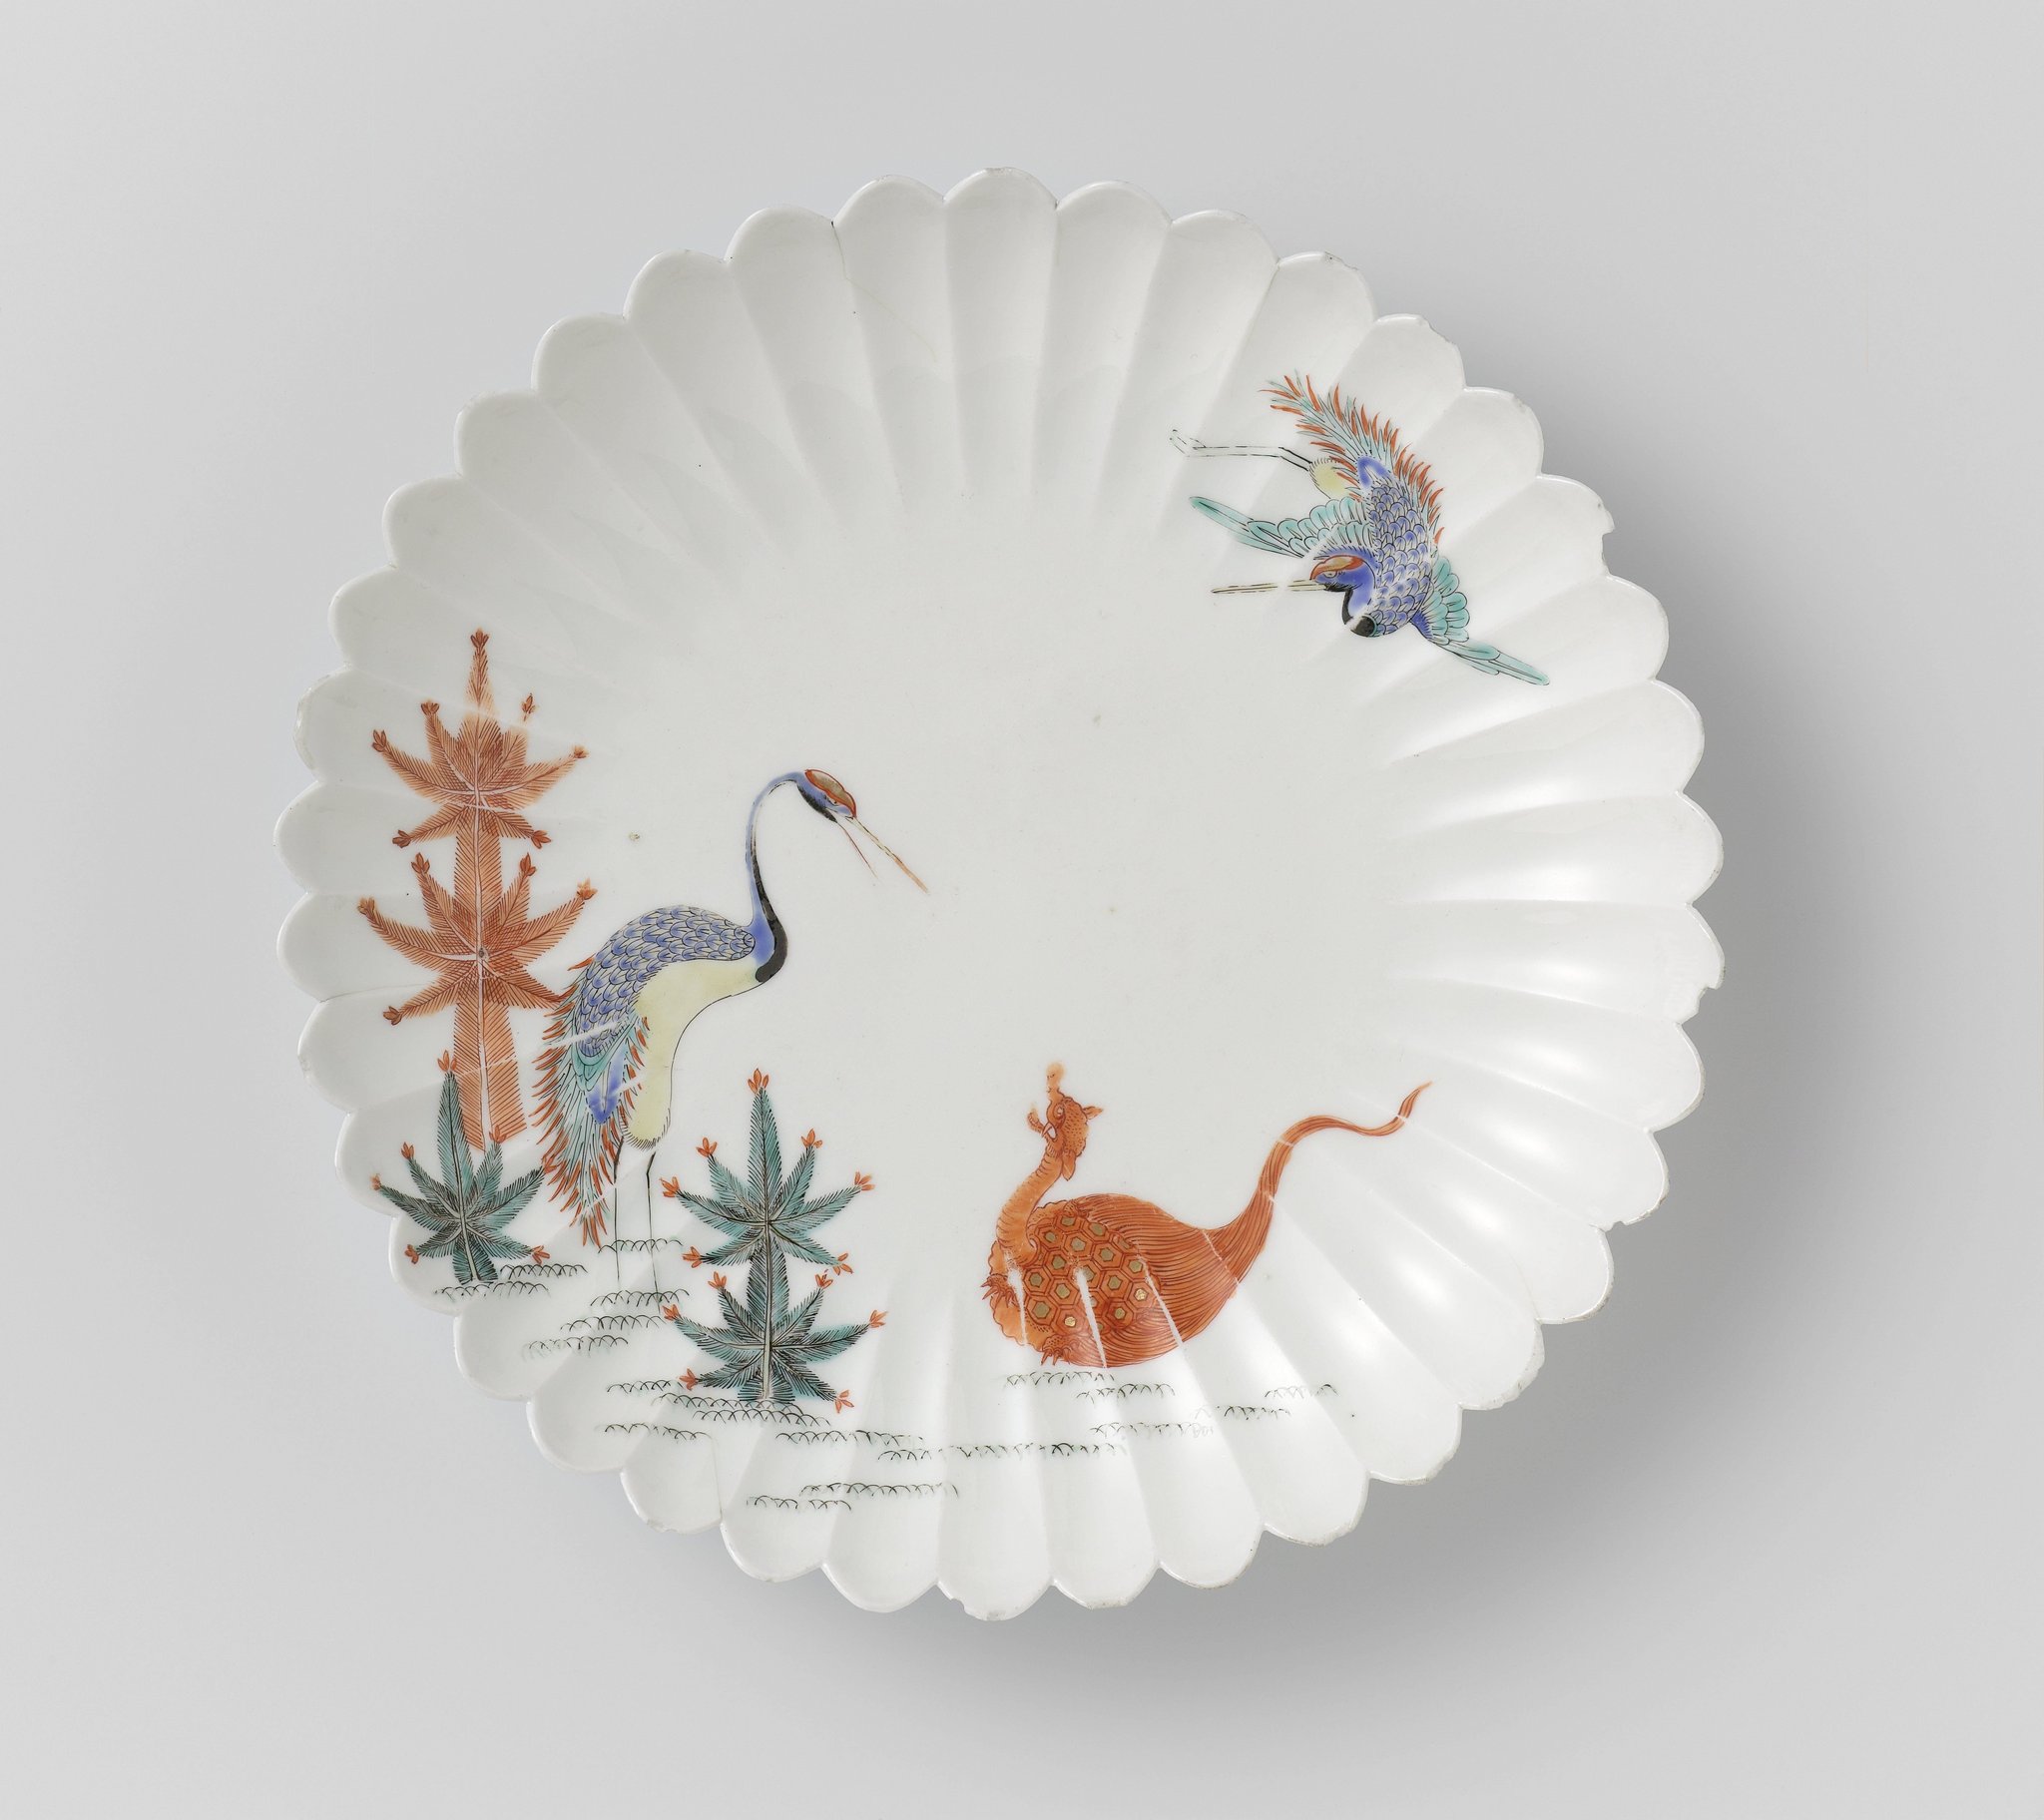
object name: dish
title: Fluted saucer-dish with cranes, minogame and pine shoots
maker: Anonymous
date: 1670-1690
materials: glaze, gold, paint, porcelain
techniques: firing, forming, gilding, turning, vitrification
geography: japan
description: Dish c. 1680 - 1700